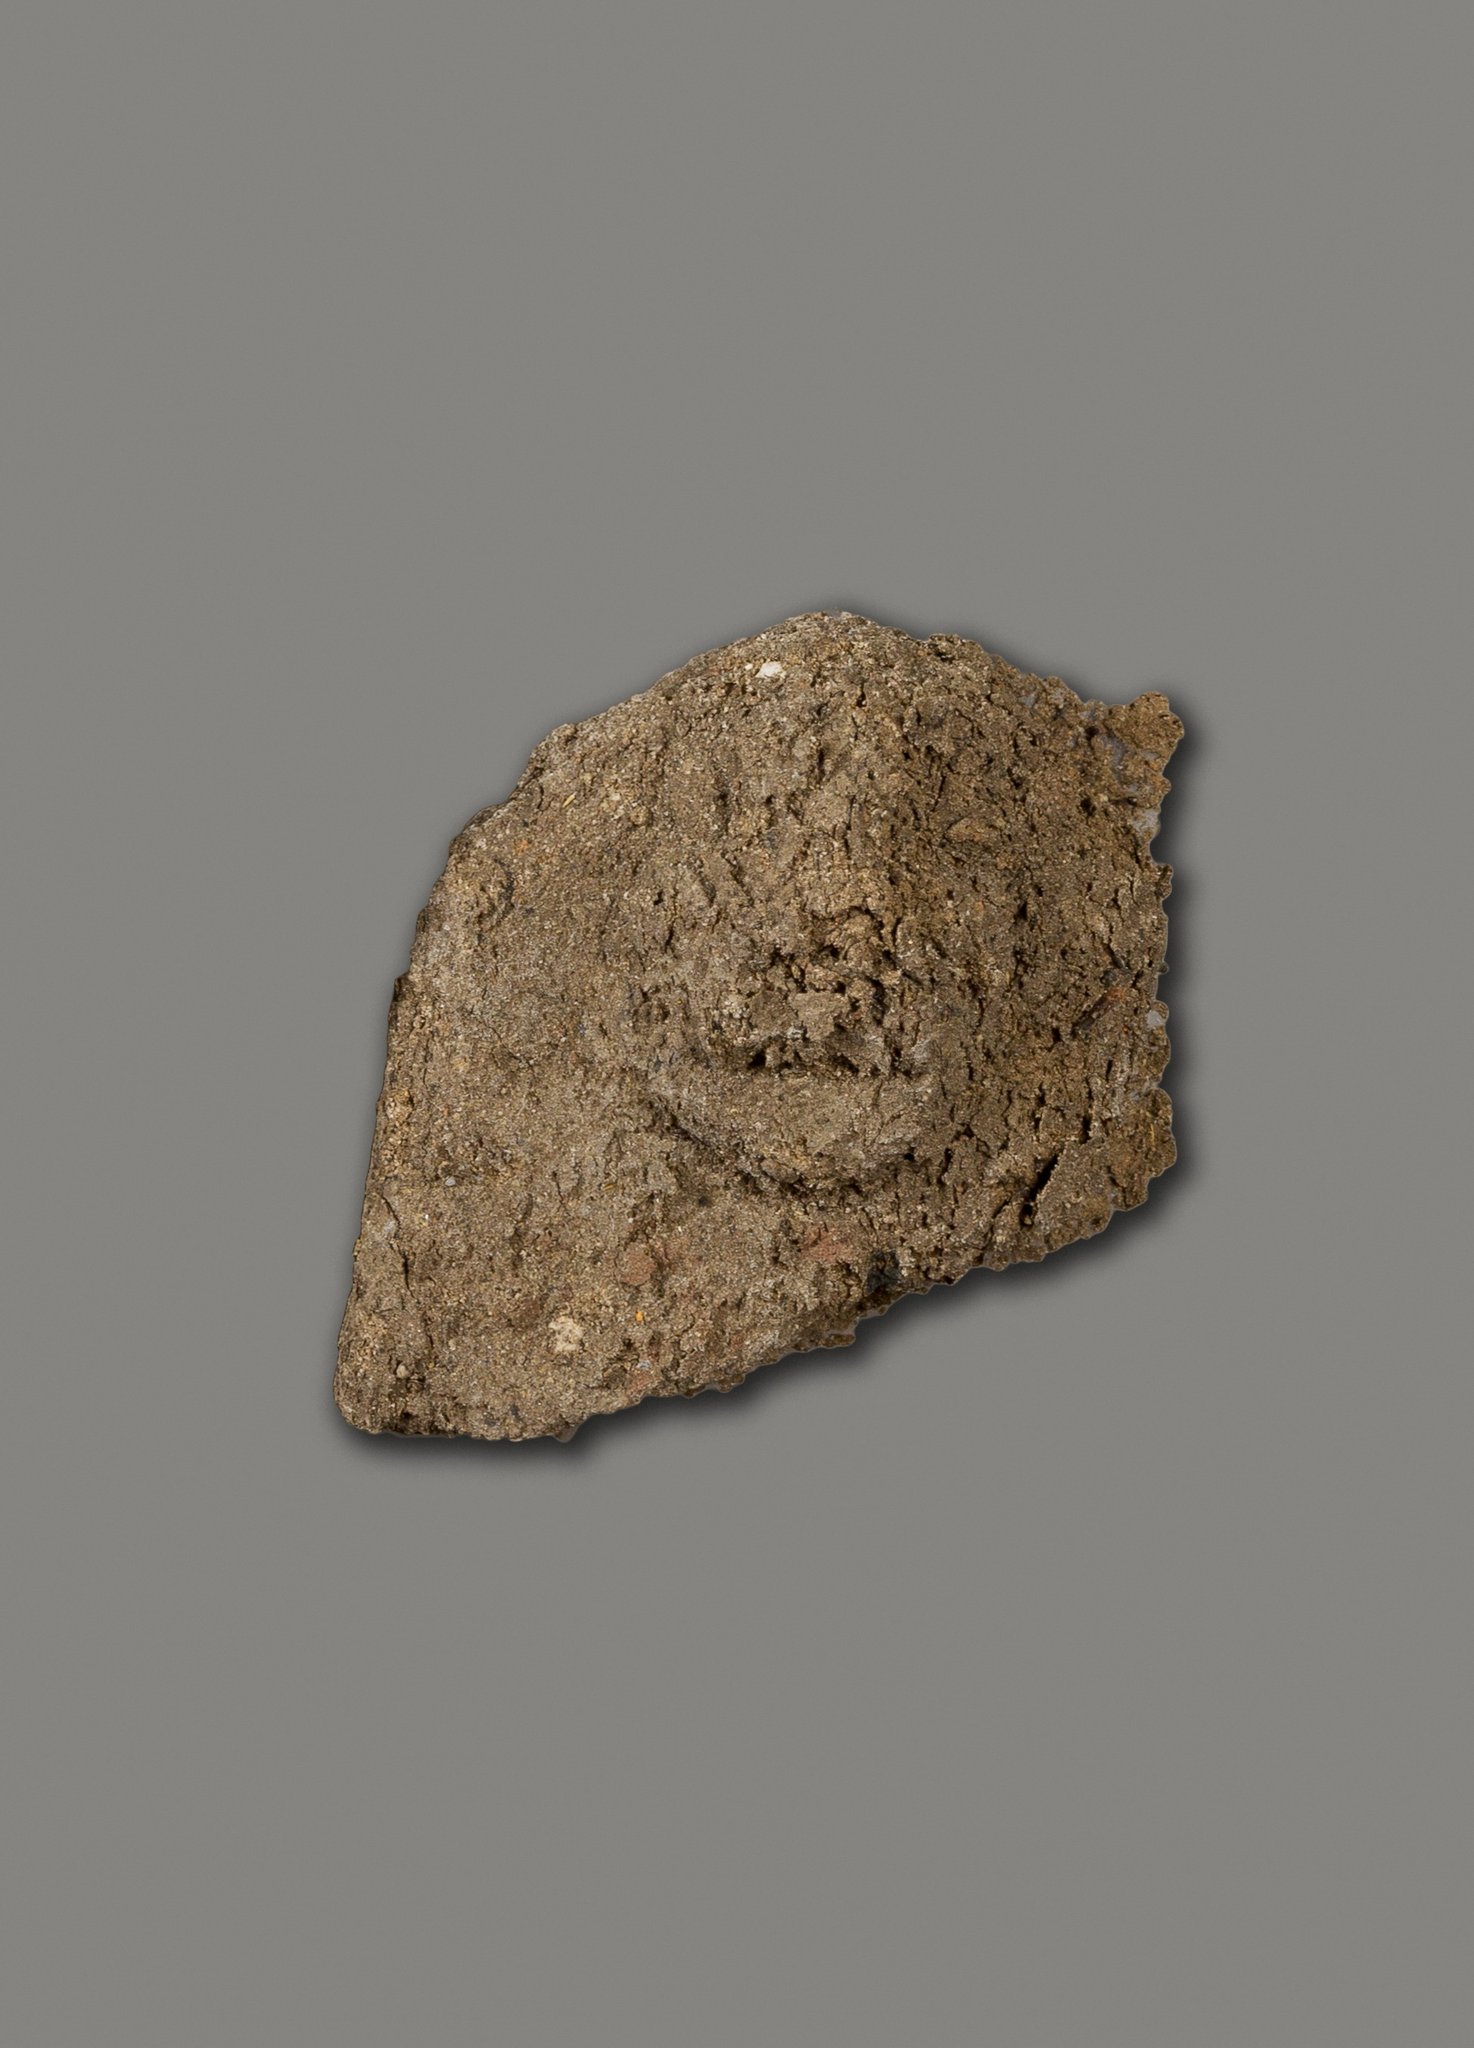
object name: figure, magical, execration, tablet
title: Magical Figure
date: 1802-1550 BCE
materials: clay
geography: egypt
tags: faces